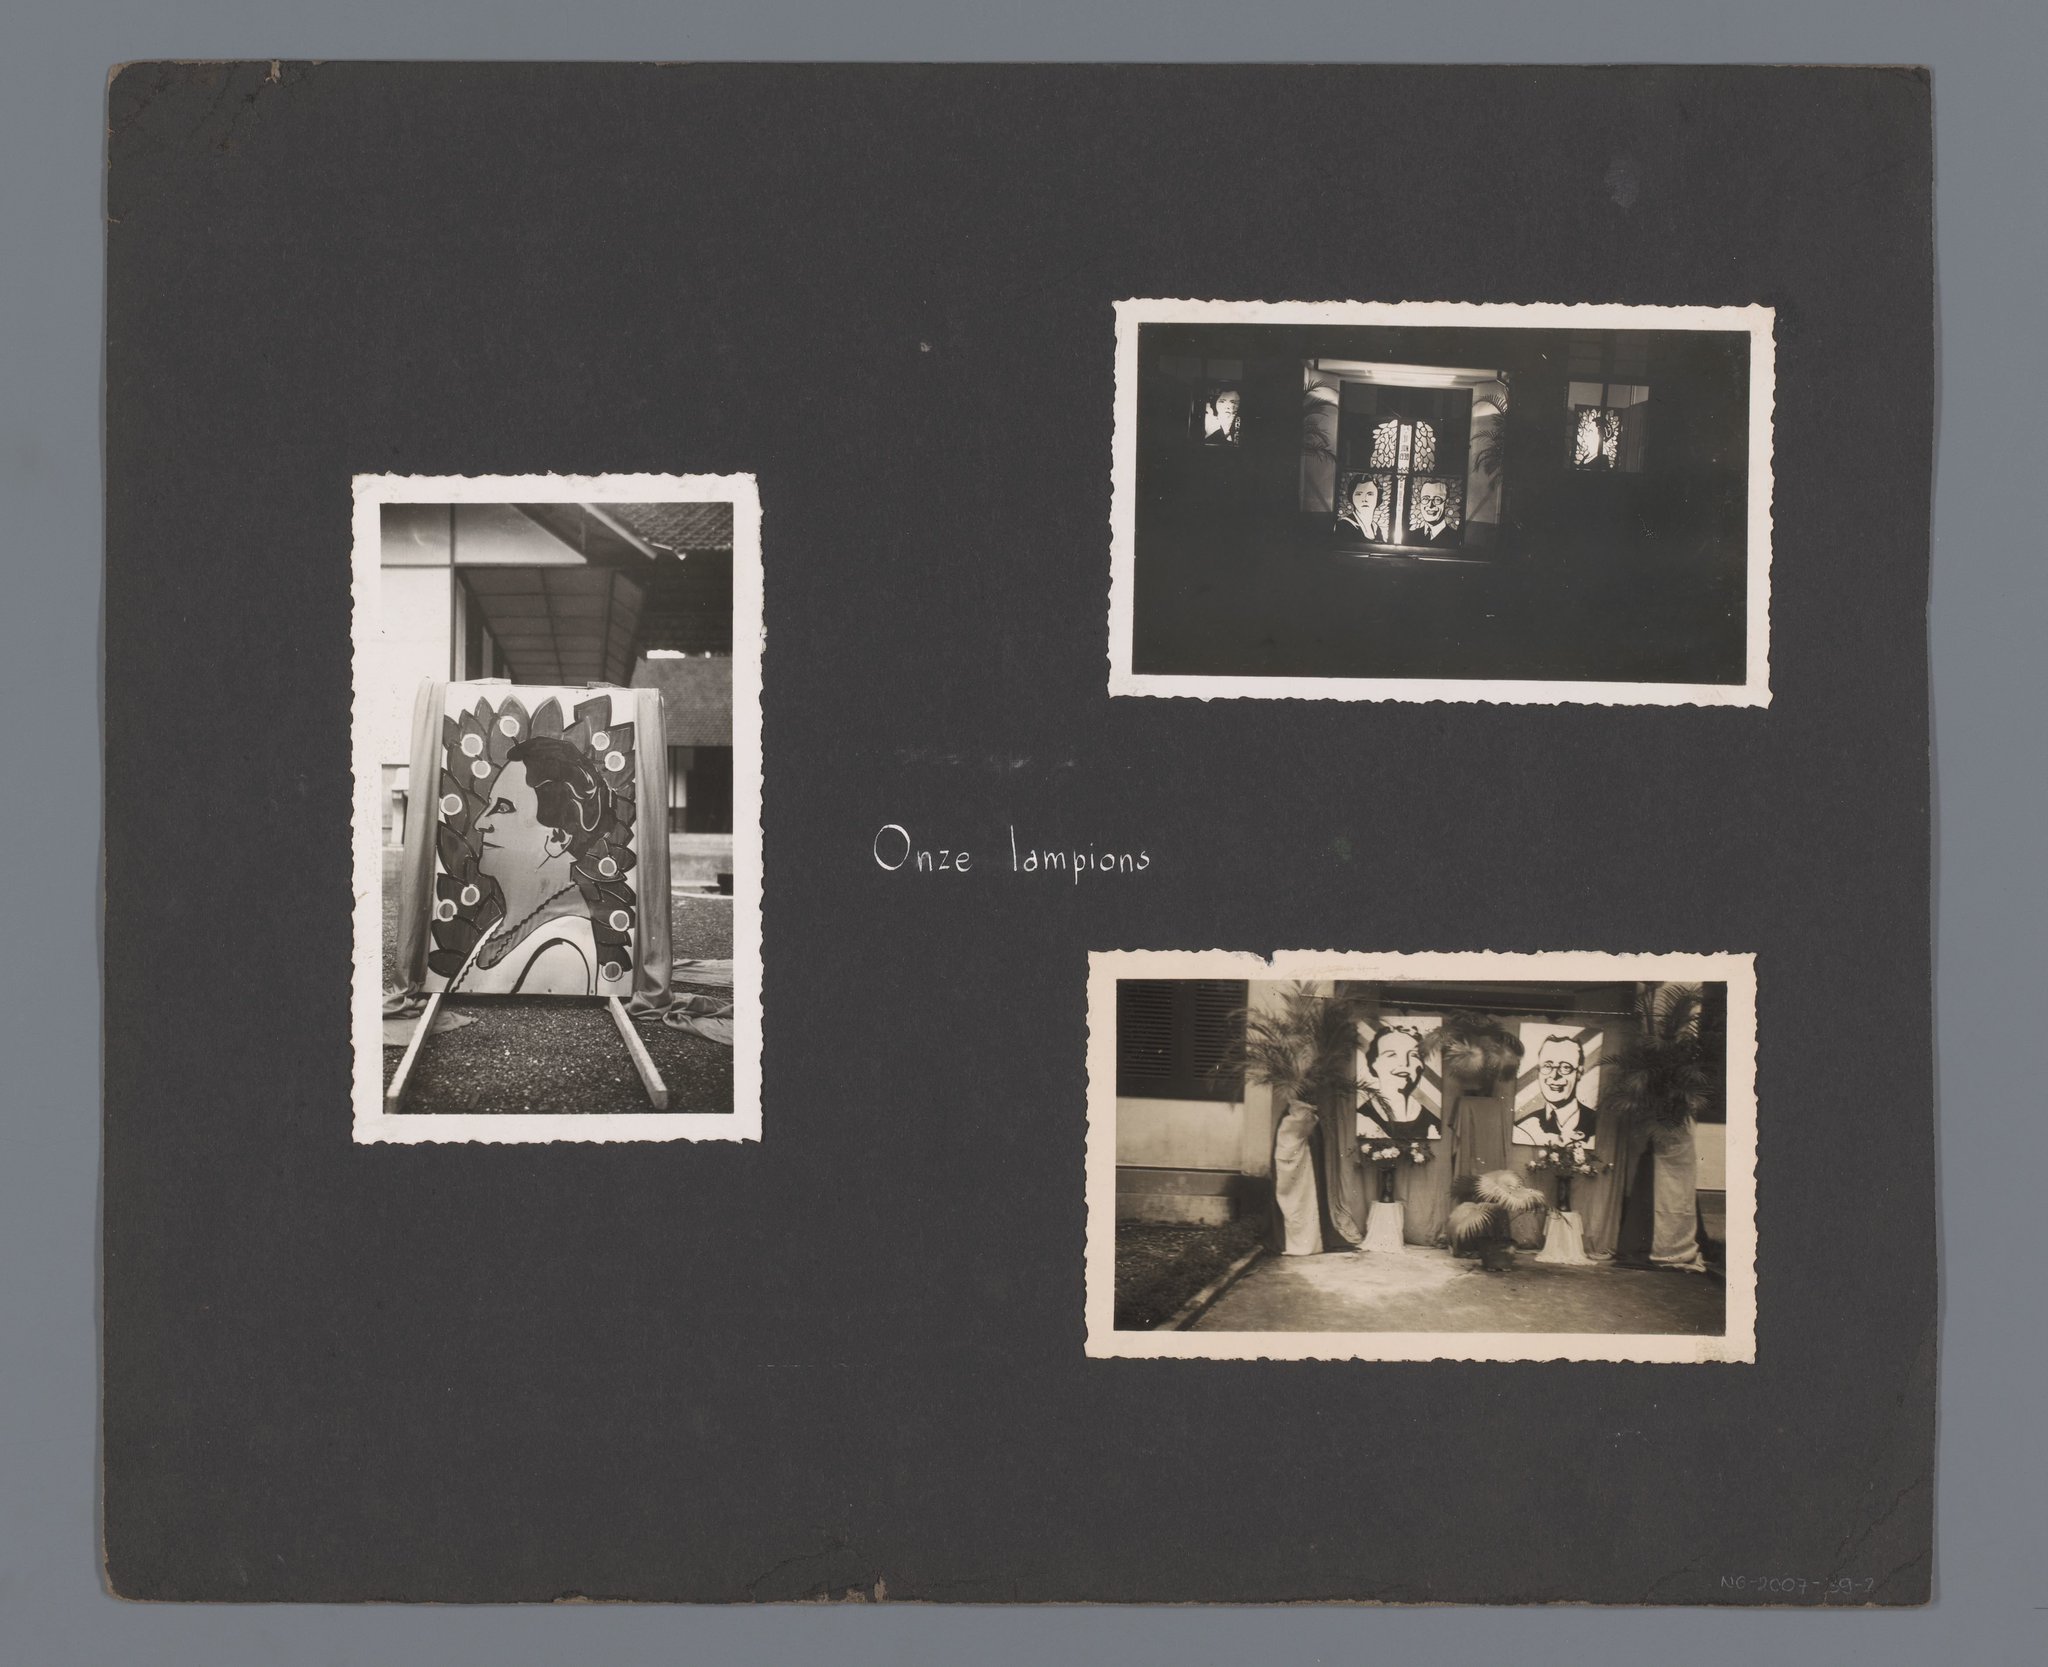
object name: album leaf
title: Onze lampions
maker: Anonymous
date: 1902-1938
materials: paper, photographic support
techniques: gelatin silver print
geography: dutch east indies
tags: wilhelmina of the netherlands, utrecht, bernhard (prins der nederlanden), beatrix (koningin der nederlanden), the hague, juliana of the netherlands, public festivities on the occasion of royal events, dutch east indies, the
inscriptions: annotation: ‘Onze lampions’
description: De Oranjefeesten werden vermoedelijke gehouden ter gelegenheid van het huwelijk tussen Juliana en Bernhard (07-01-1937) en/of de geboorte van Beatrix (31-01-1938). Fr. M.T. Horsten (zie documentatie) meldt dat de fraters van Tilburg zich in Indië niet onbetuigd lieten bij 'Vaderlandse feestelijke gelegenheden', zowel op Celebes als Sumatra.